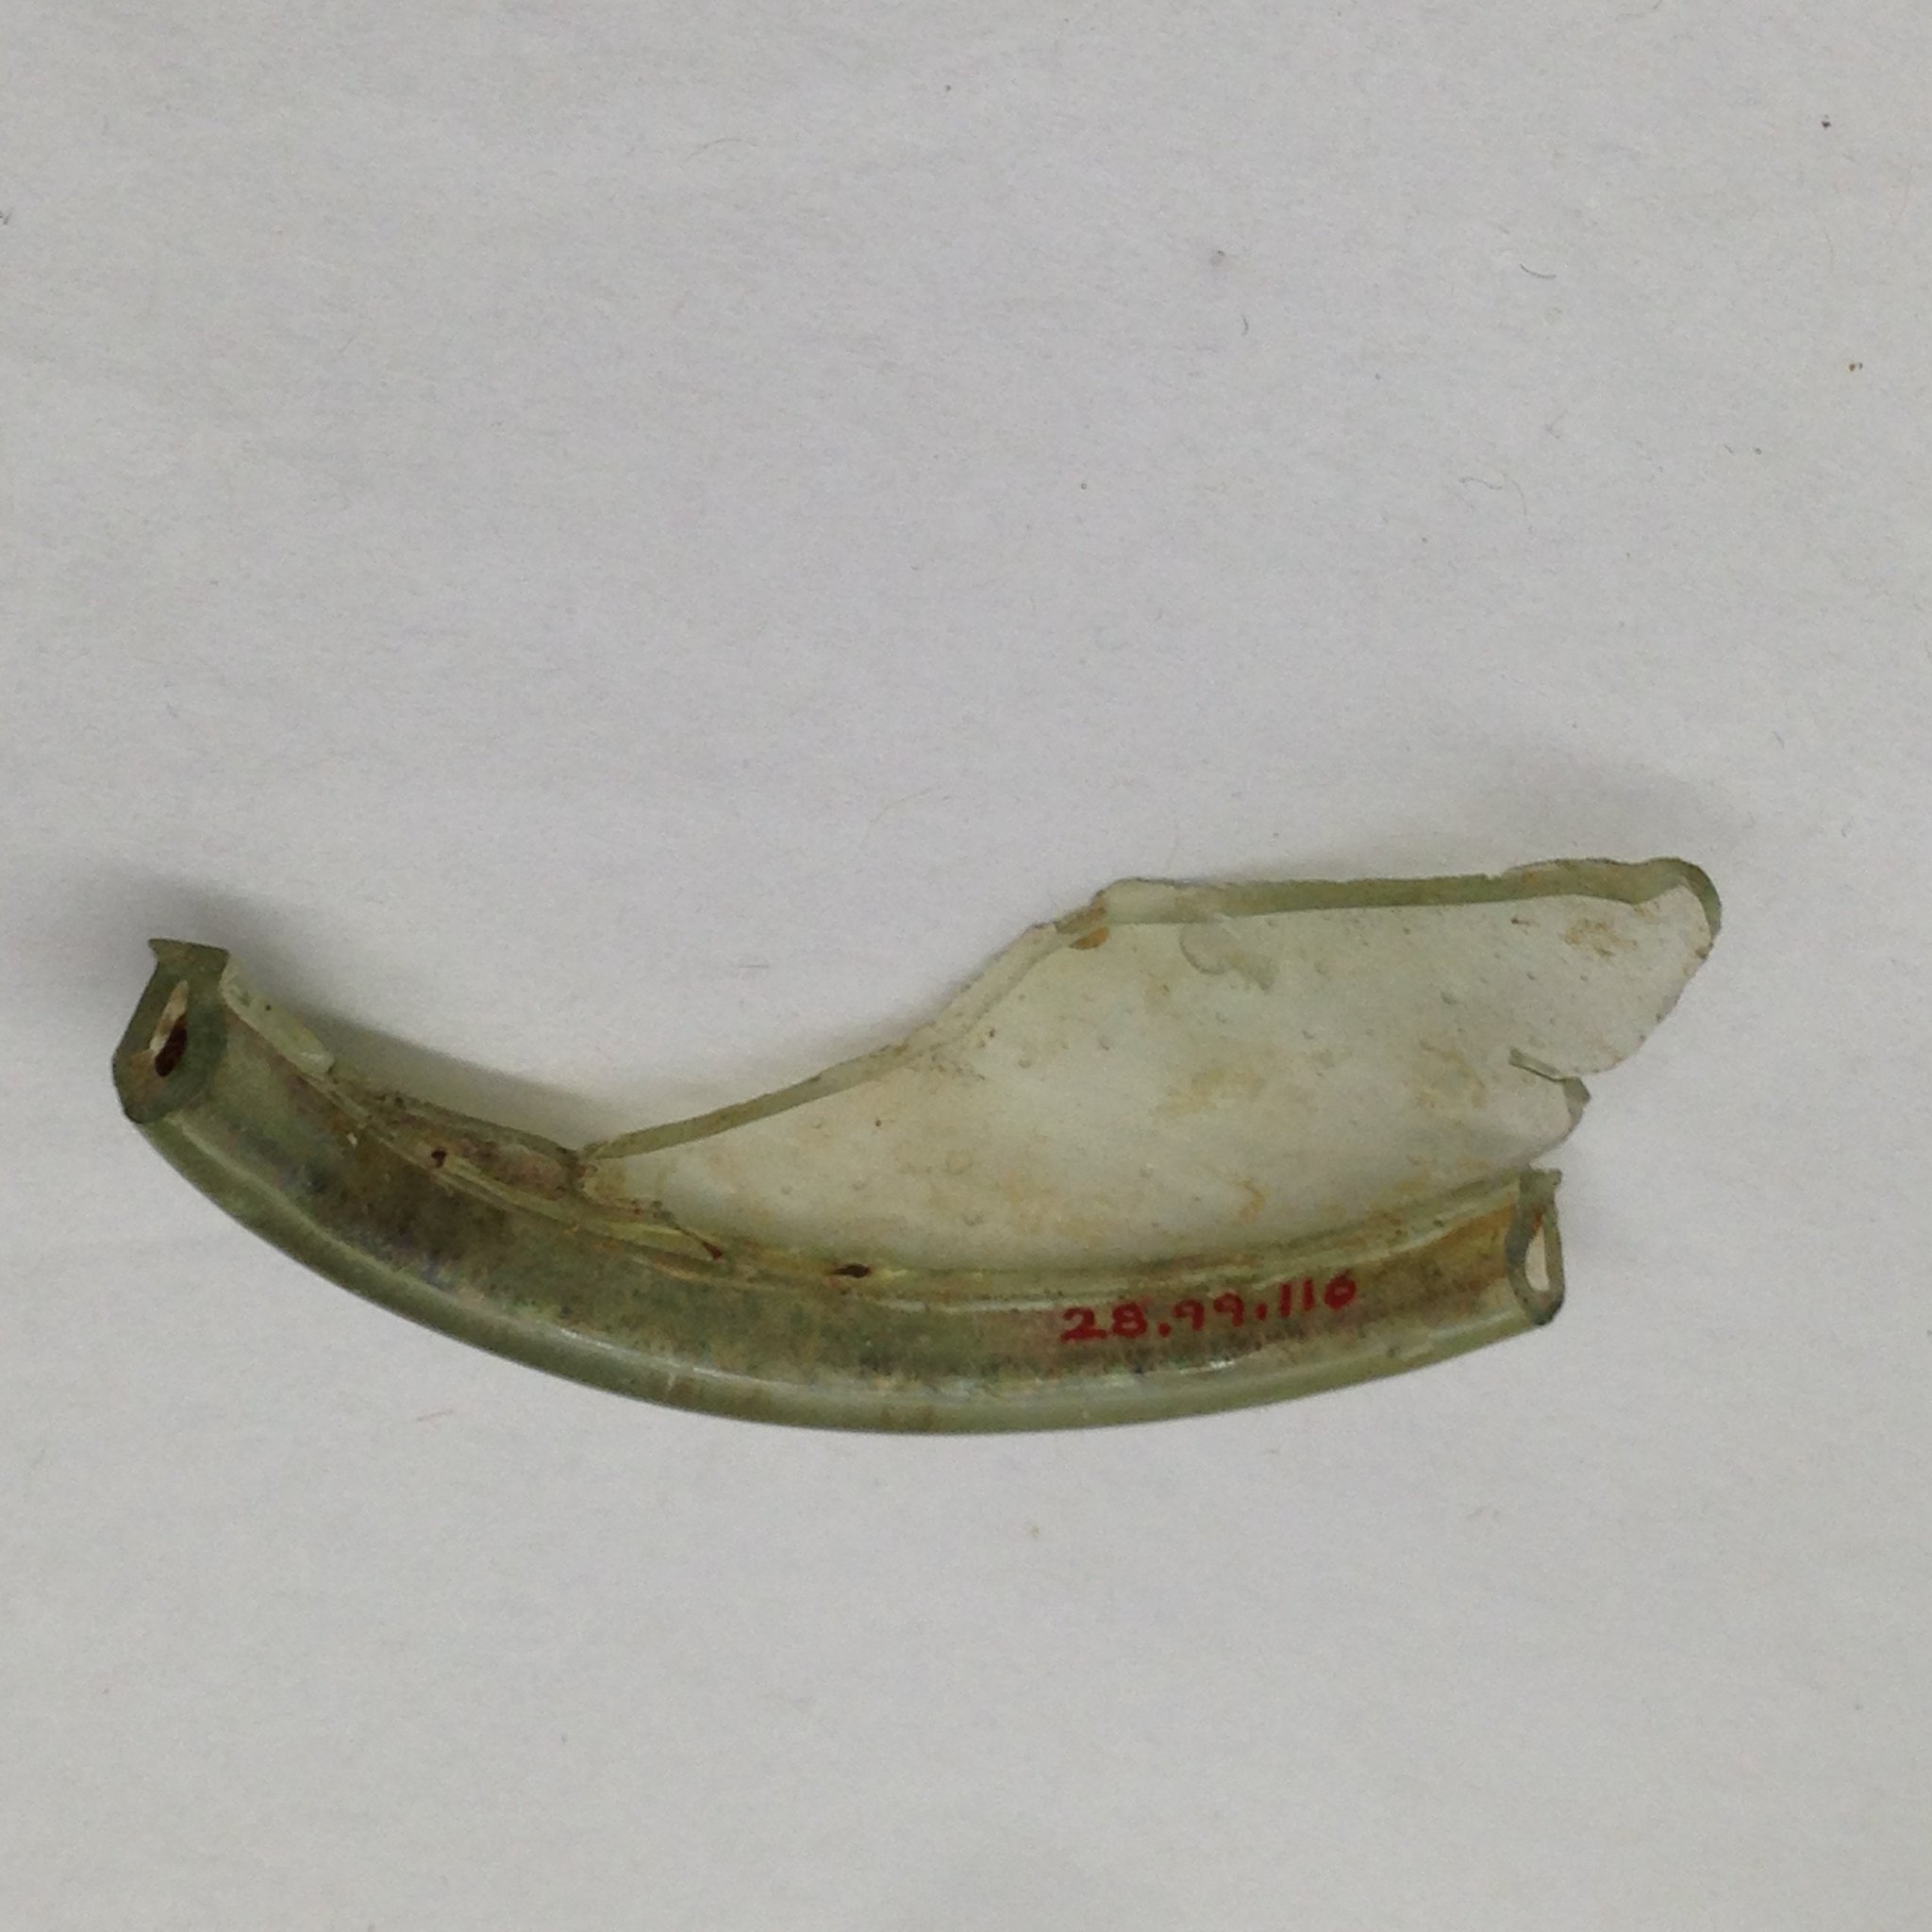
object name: fragment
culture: european or middle eastern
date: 1150-1250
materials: ceramic, glass